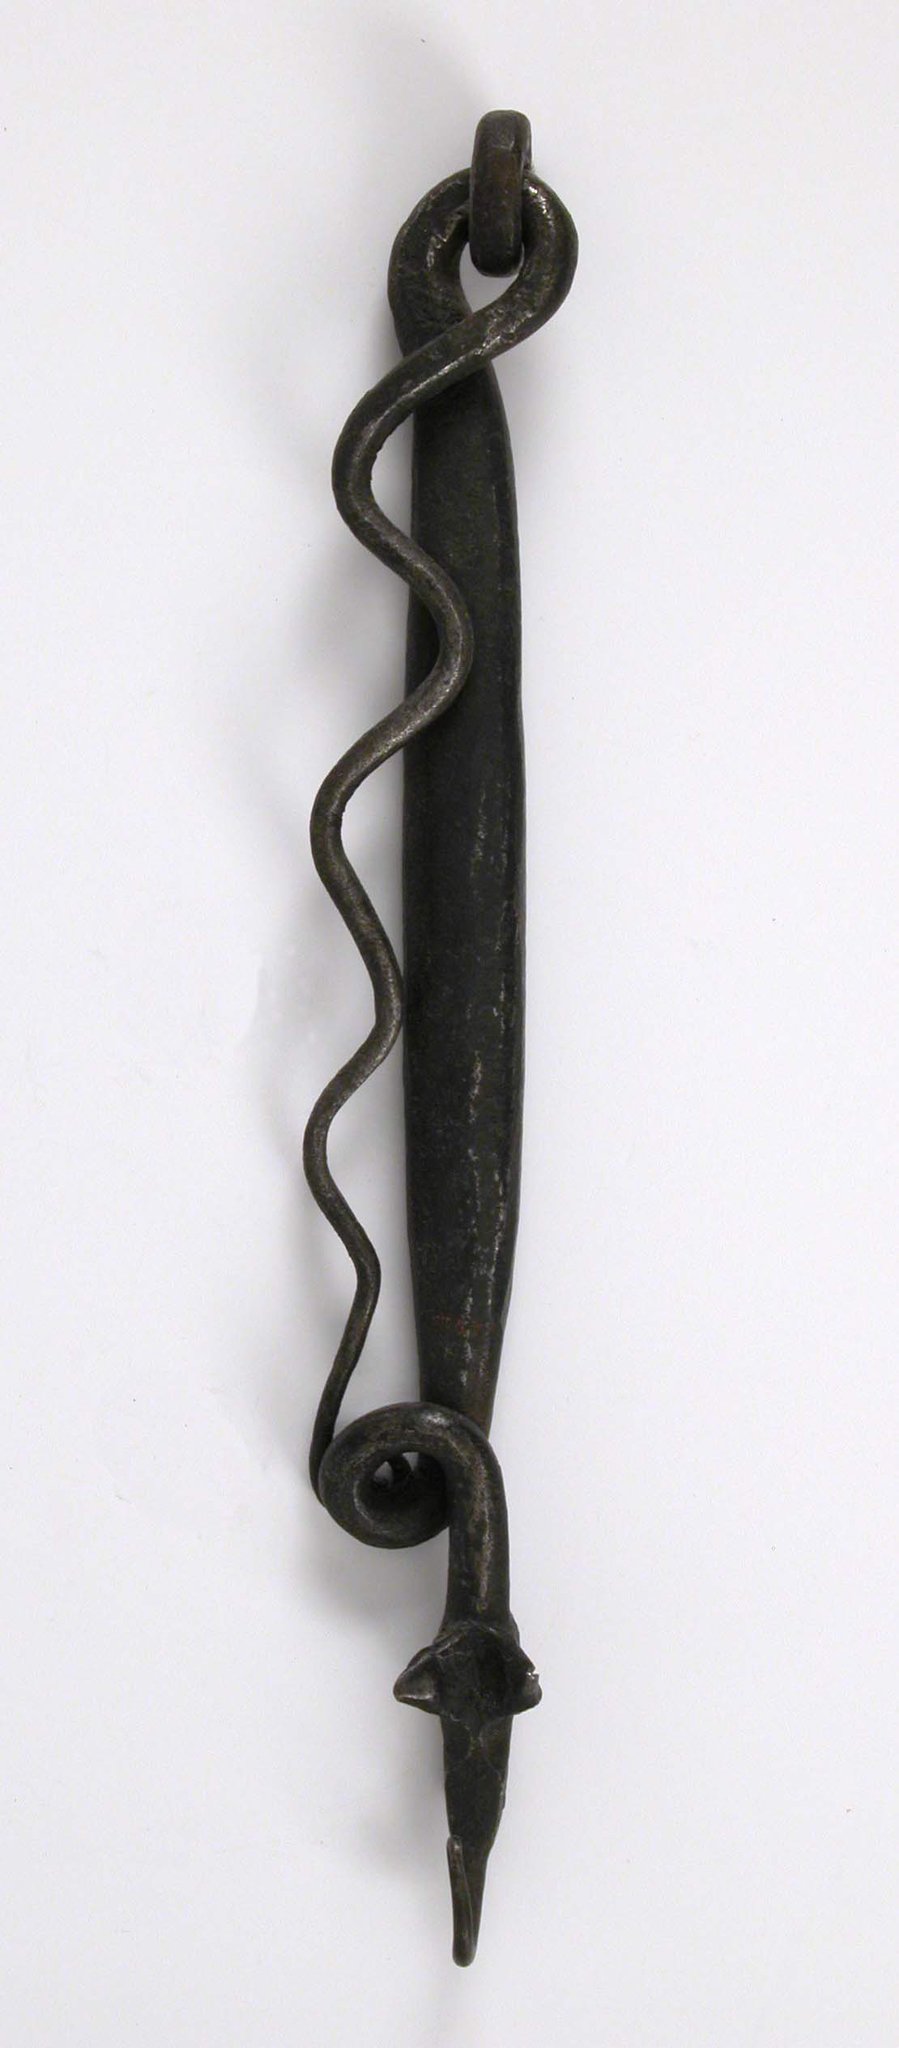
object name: door rasp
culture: german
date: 1401-1600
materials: iron